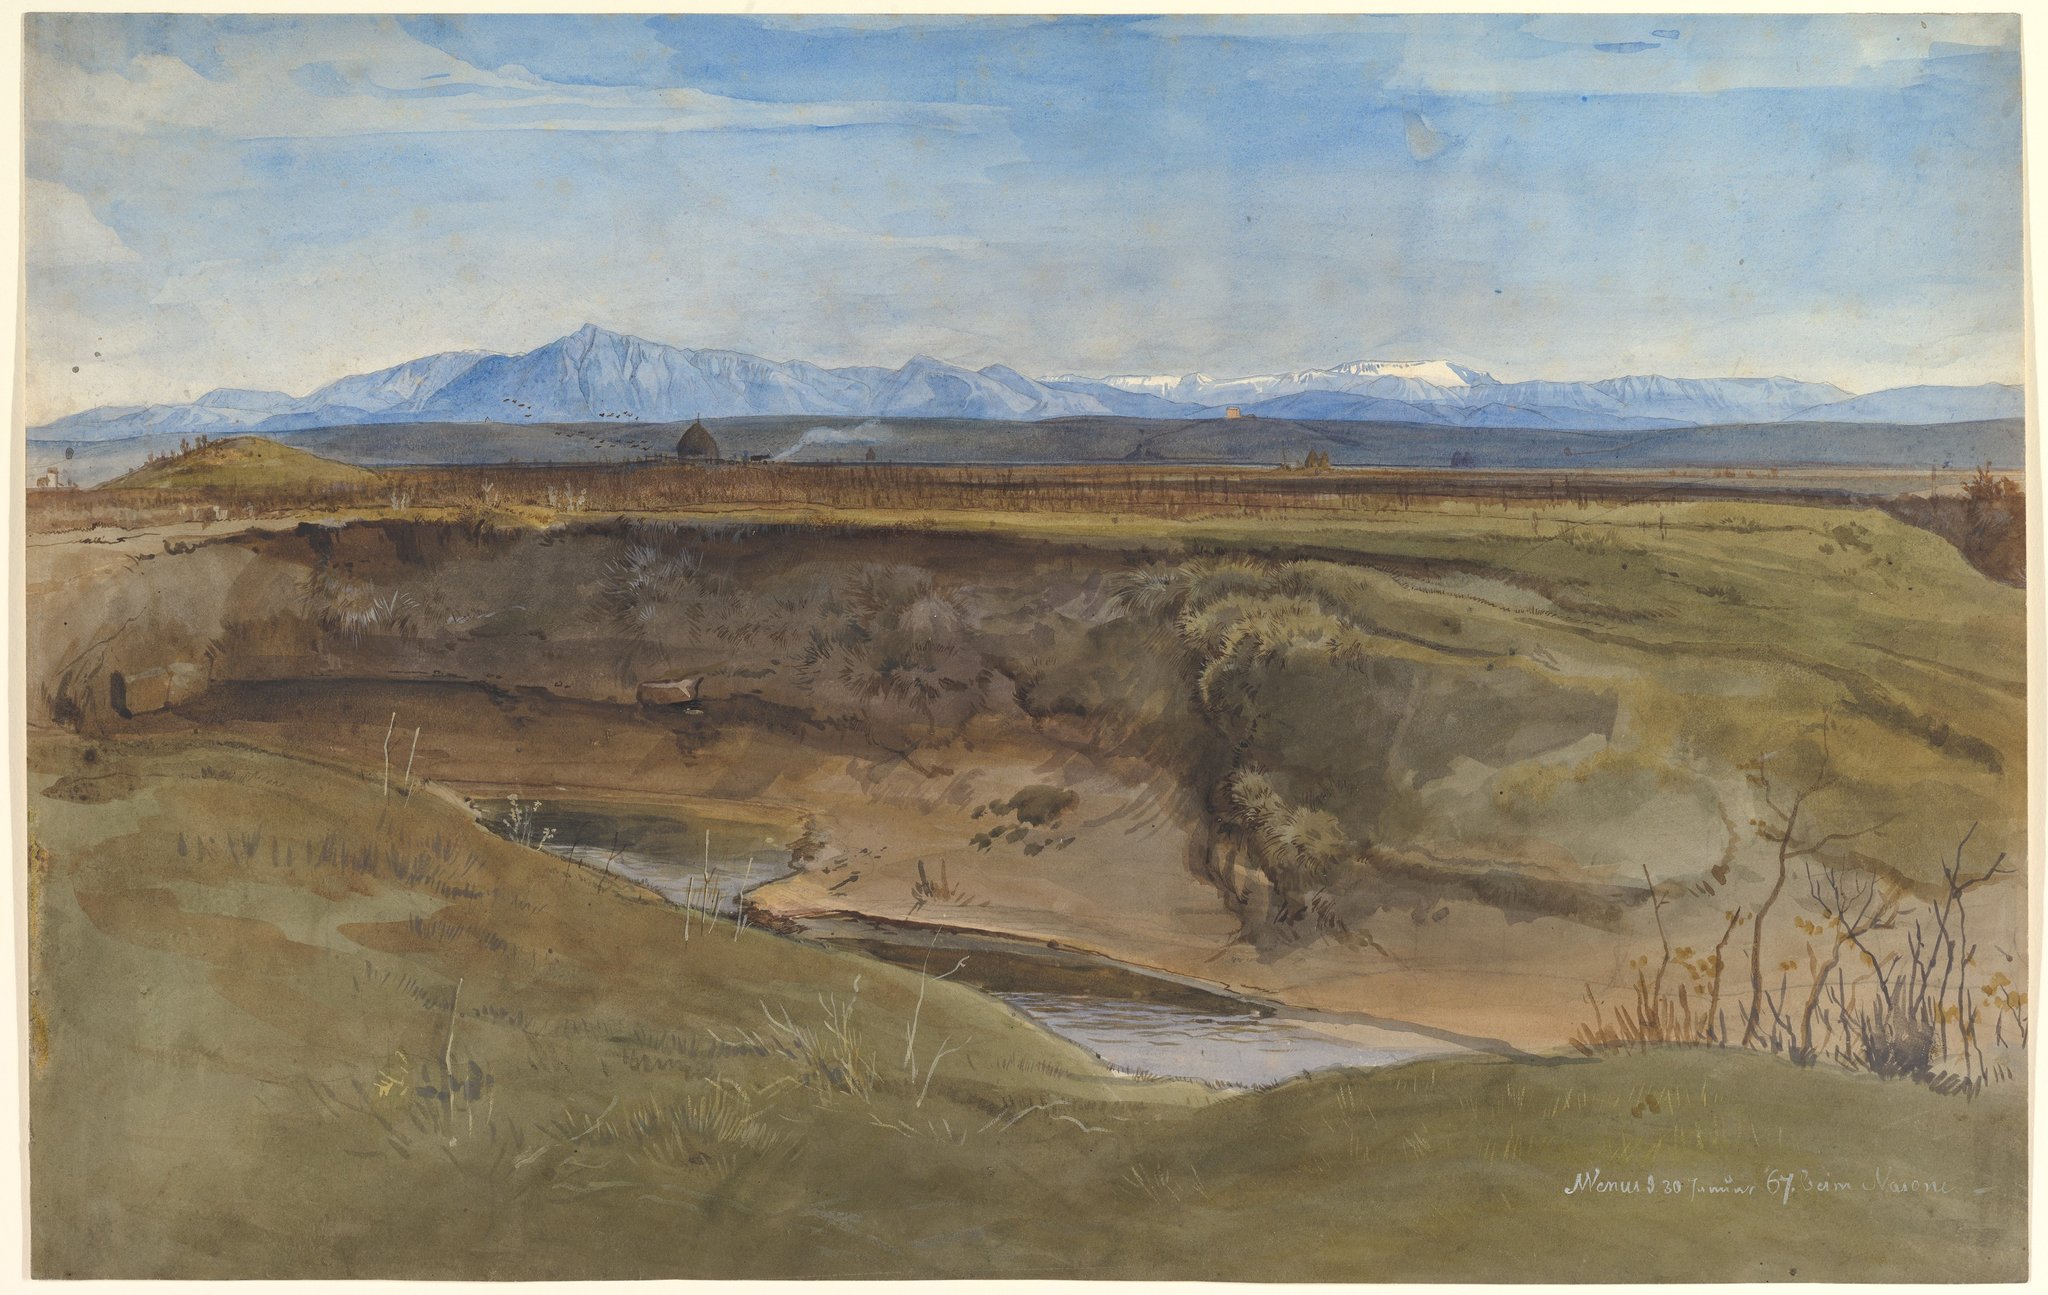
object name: drawing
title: Landscape near Rome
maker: albert venus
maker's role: artist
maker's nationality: german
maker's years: 1842-1871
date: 1867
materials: chalk, gouache, ink, watercolor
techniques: brush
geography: germany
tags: mountains,landscapes